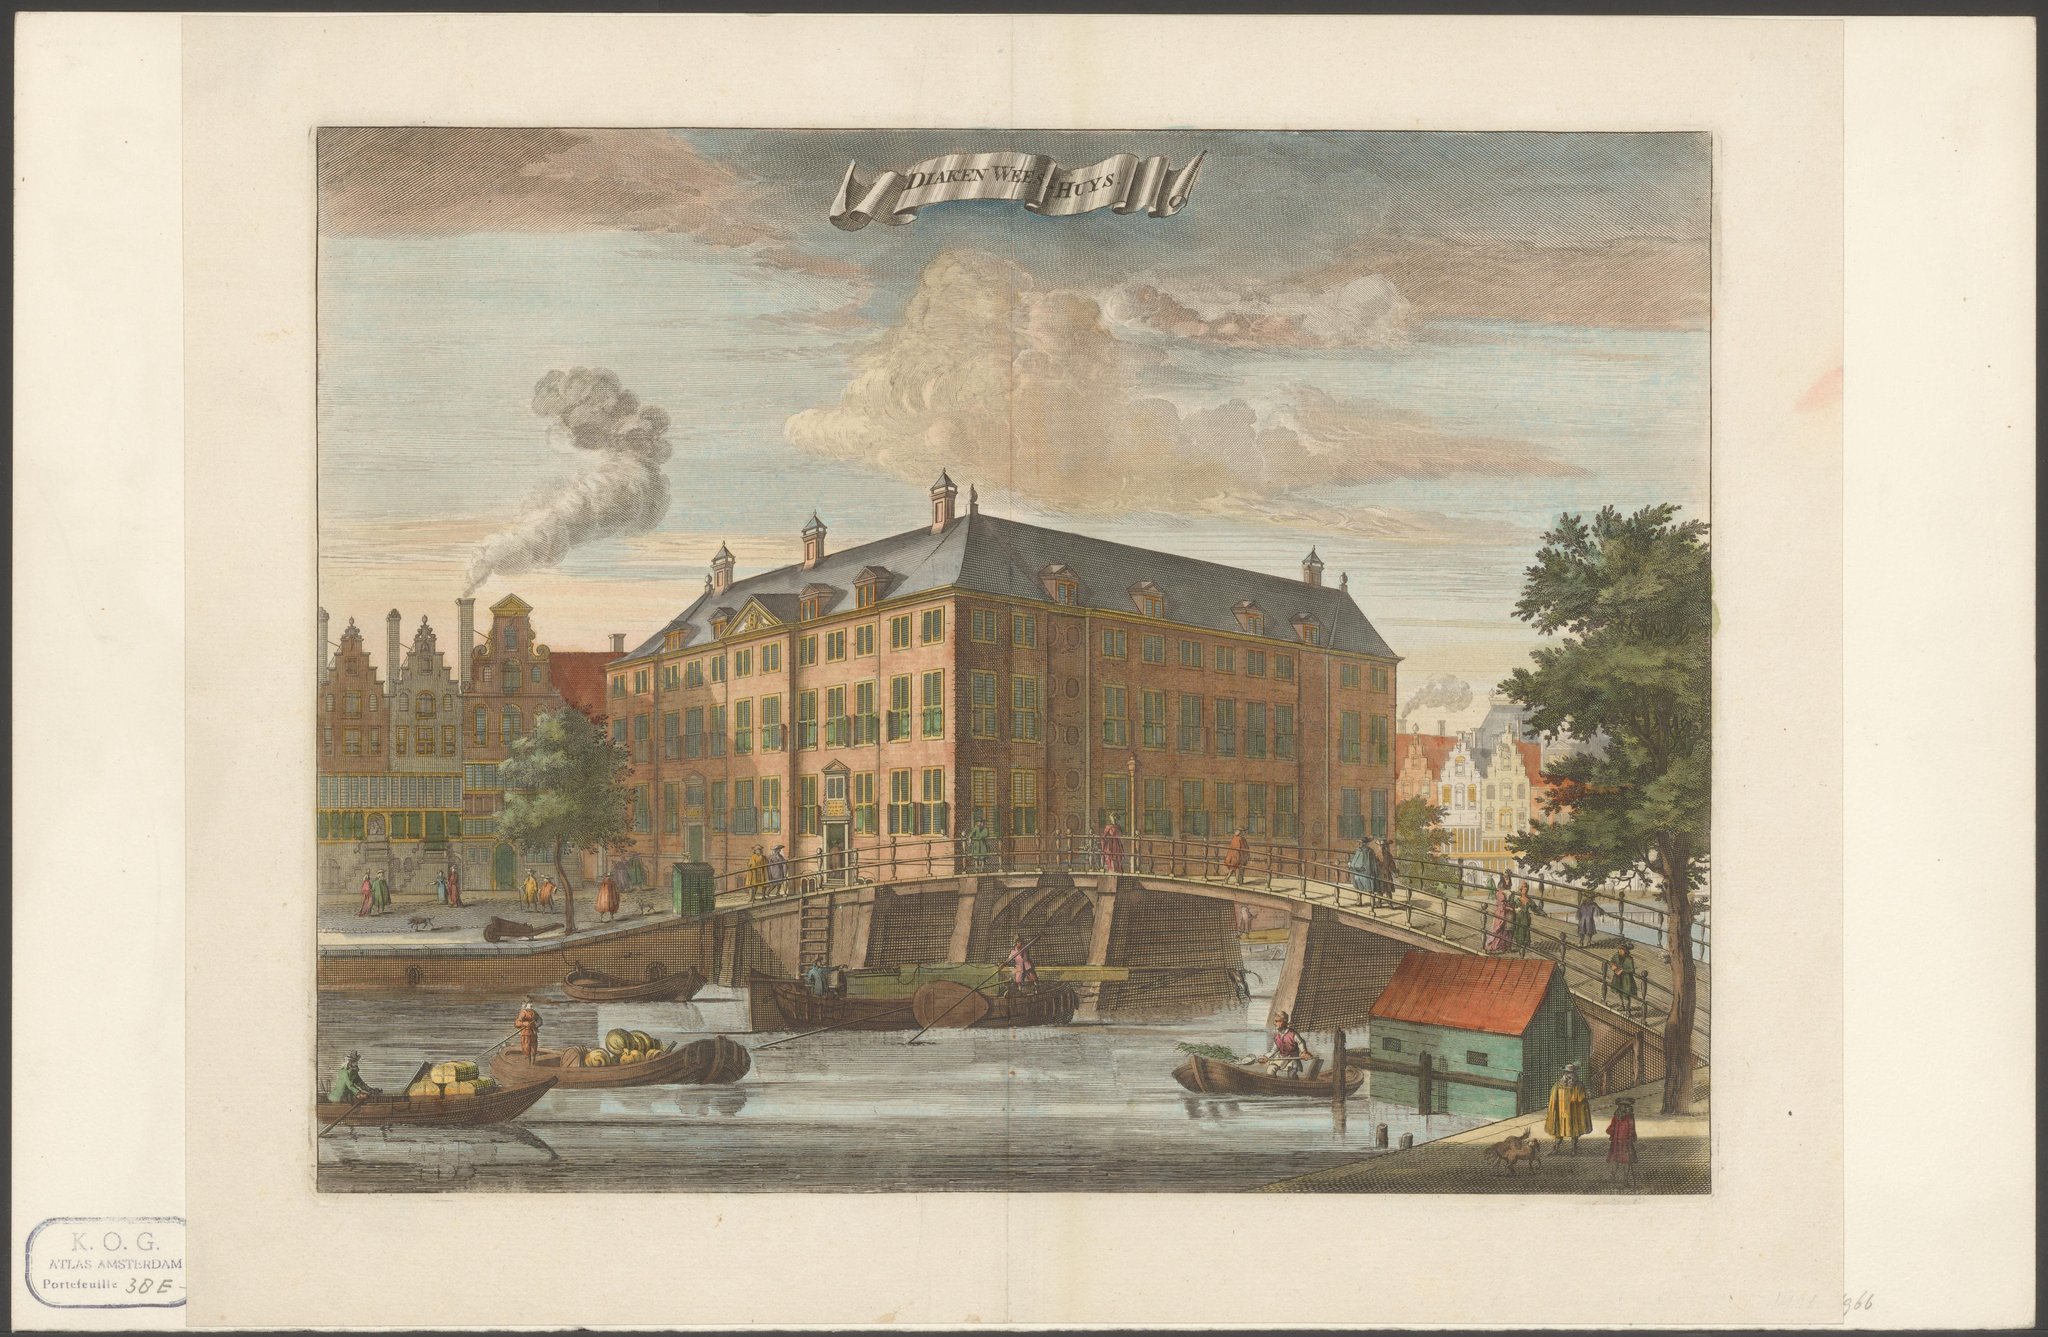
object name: print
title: Diaken Wees-huys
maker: Anonymous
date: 1726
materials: paper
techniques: engraving, etching, hand coloring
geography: northern netherlands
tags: bridge in city across river, canal, etc. (+ city(-scape) with figures, staffage), rowing-boat, canoe, etc., orphanage, canals, waters (in city) (+ city(-scape) with figures, staffage)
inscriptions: collector's mark: Lugt 1641b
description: Huidige staat van prent ook gebruikt in: Commelin, Casparus. Beschryvinge van Amsterdam (…). 2de druk. Amsterdam: Andries van Damme, Johannes Ratelband, weduwe Antony van Aeltwijk en Hermanus Uytwerf, 1726, dl. 2. Eerste staat van prent (zonder opgewerkte lucht- en waterpartijen) ook gebruikt in: Commelin, Casparus. Beschryvinge van Amsterdam (…). Amsterdam: Abraham Wolfgang, Gillis Janssonius van Waesberge of Johannes Janssonius van Waesberge, Hendrick Boom of weduwe Dirk Boom, Abraham van Sanderen en Rembertus Goethals, 1693, dl. 2. En in: Commelin, Casparus. Beschryvinge van Amsterdam (…). Amsterdam: weduwe Aart Dircksz. Oossaan, 1694, dl. 2.